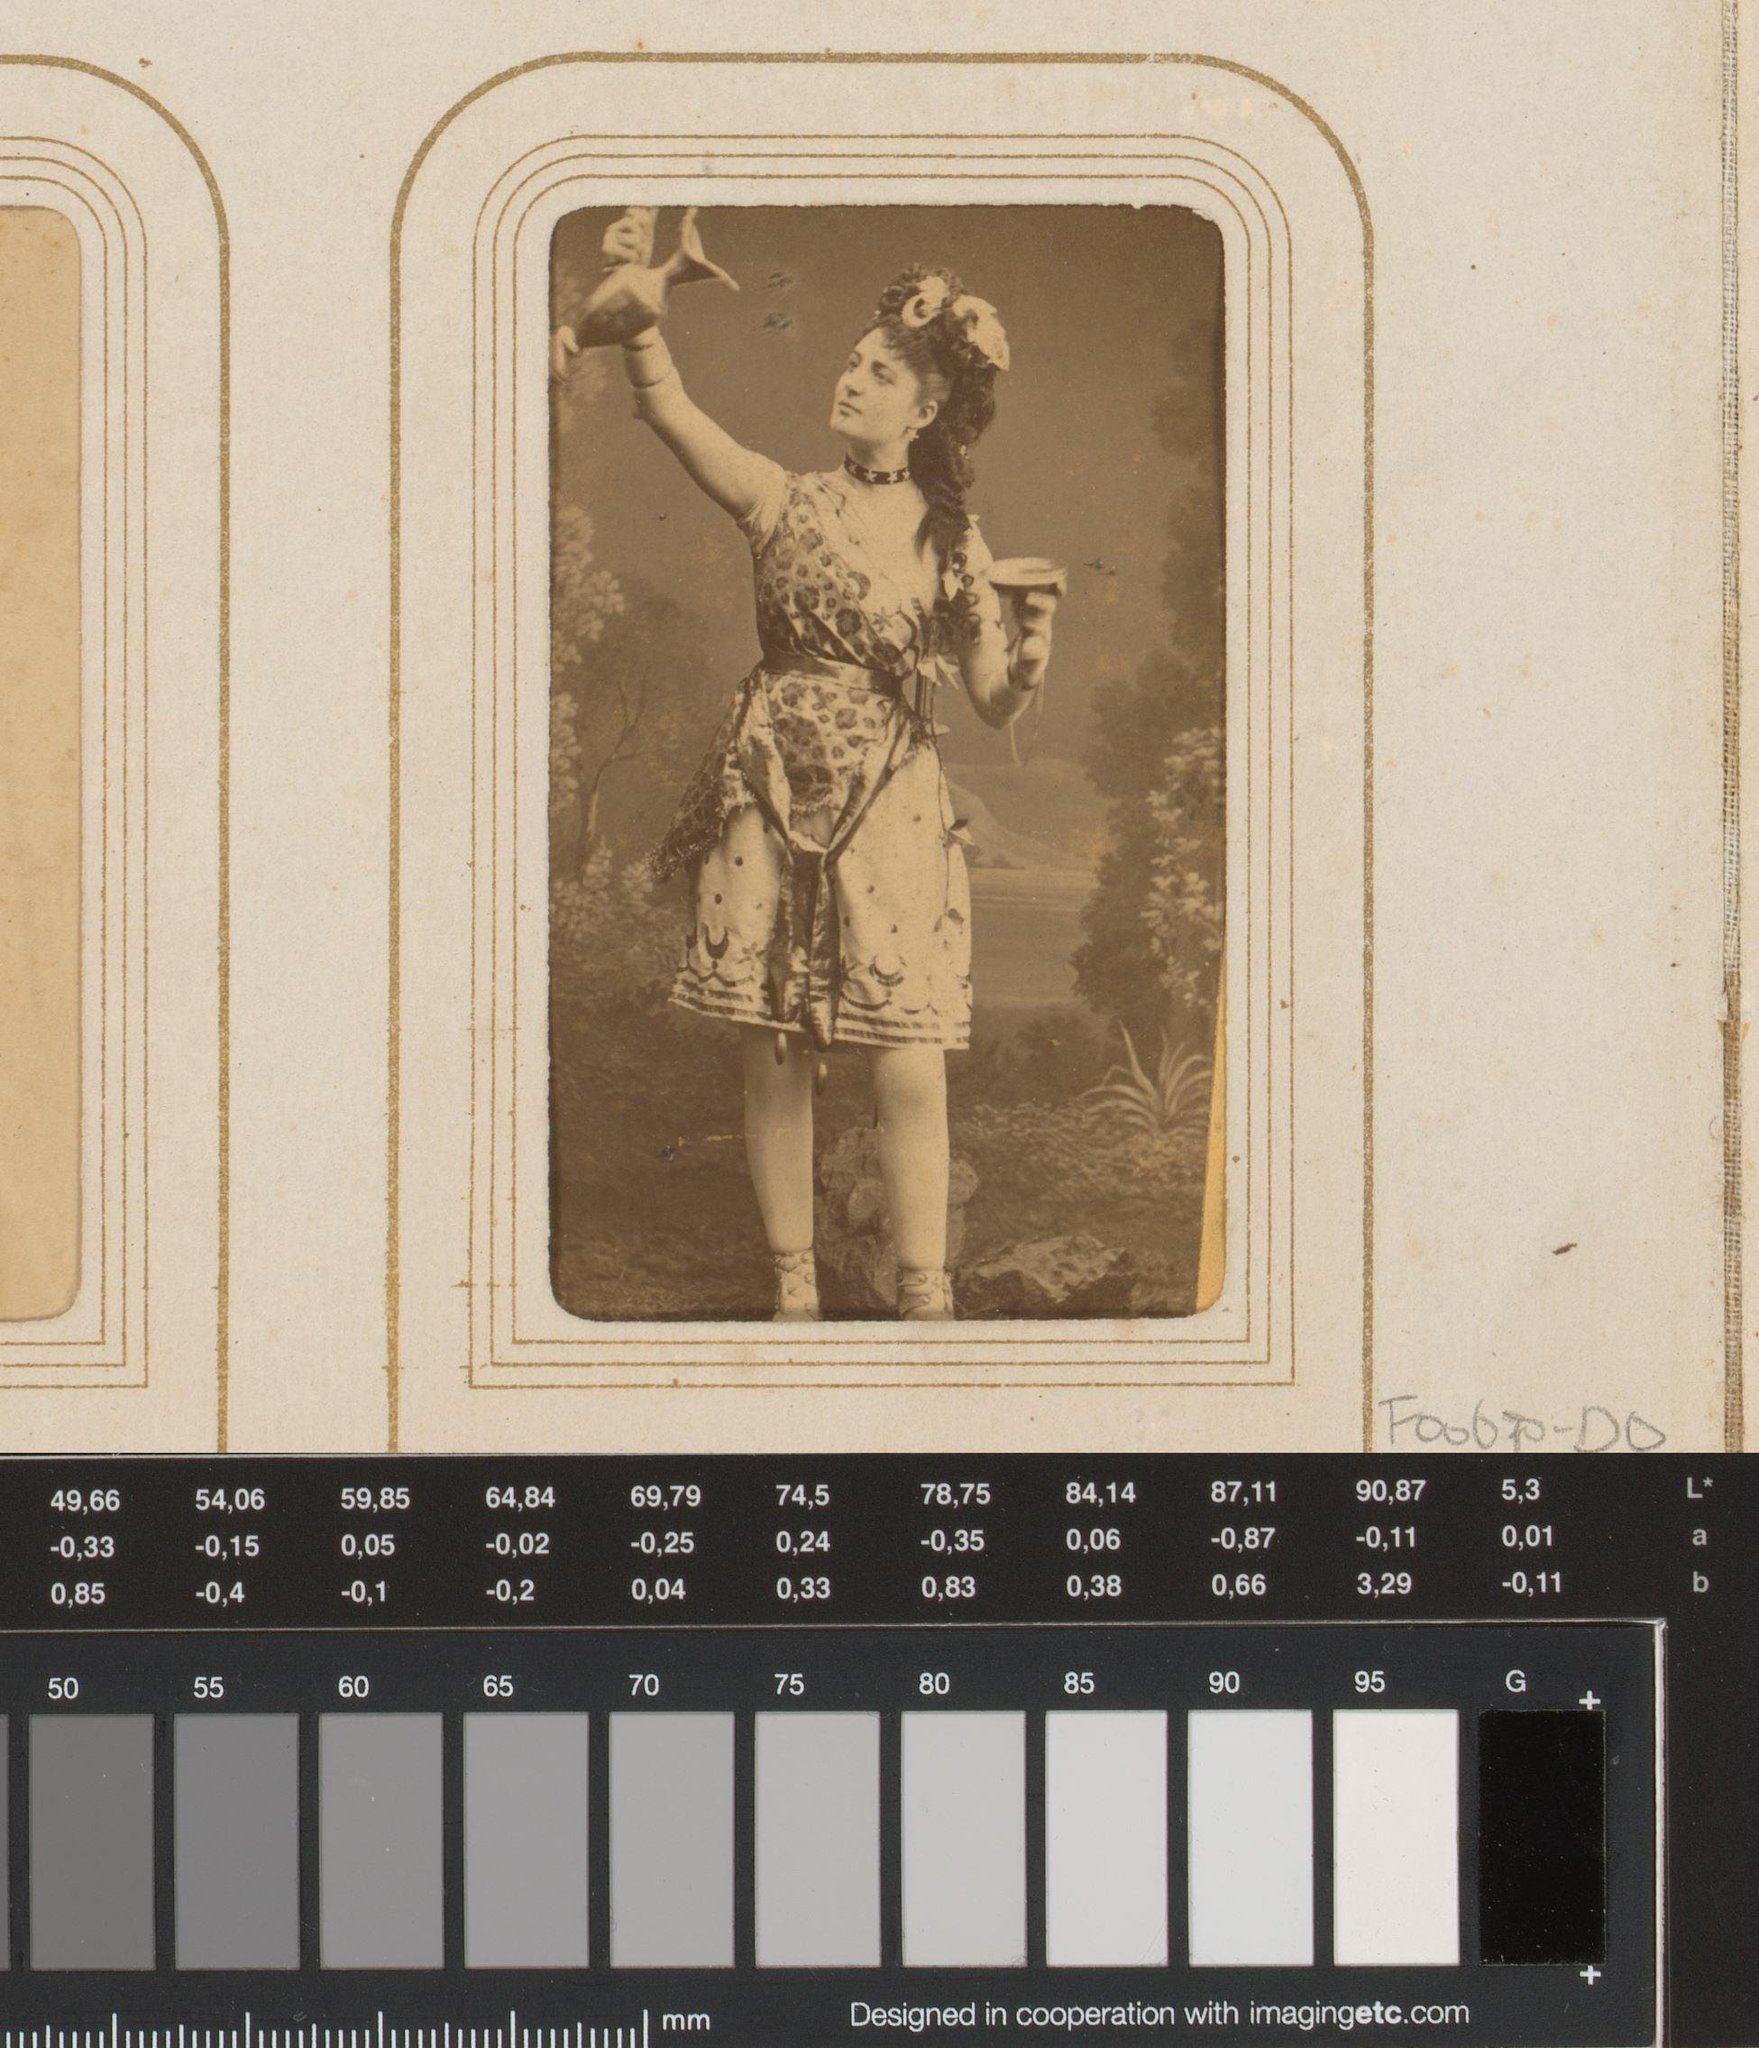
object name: album leaf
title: Portret van een vrouw met kan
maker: anatole pougnet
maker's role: publisher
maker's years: 1840-1900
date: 1860-1880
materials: cardboard, photographic support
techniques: albumen print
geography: paris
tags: historical persons - bb - woman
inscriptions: annotation: ‘Serret (Pougnet)’, name: ‘Serret’, inscription: ‘Anatole Pougnet/ Éditeur/ 61, Boulevard Sébastopol/ Paris’